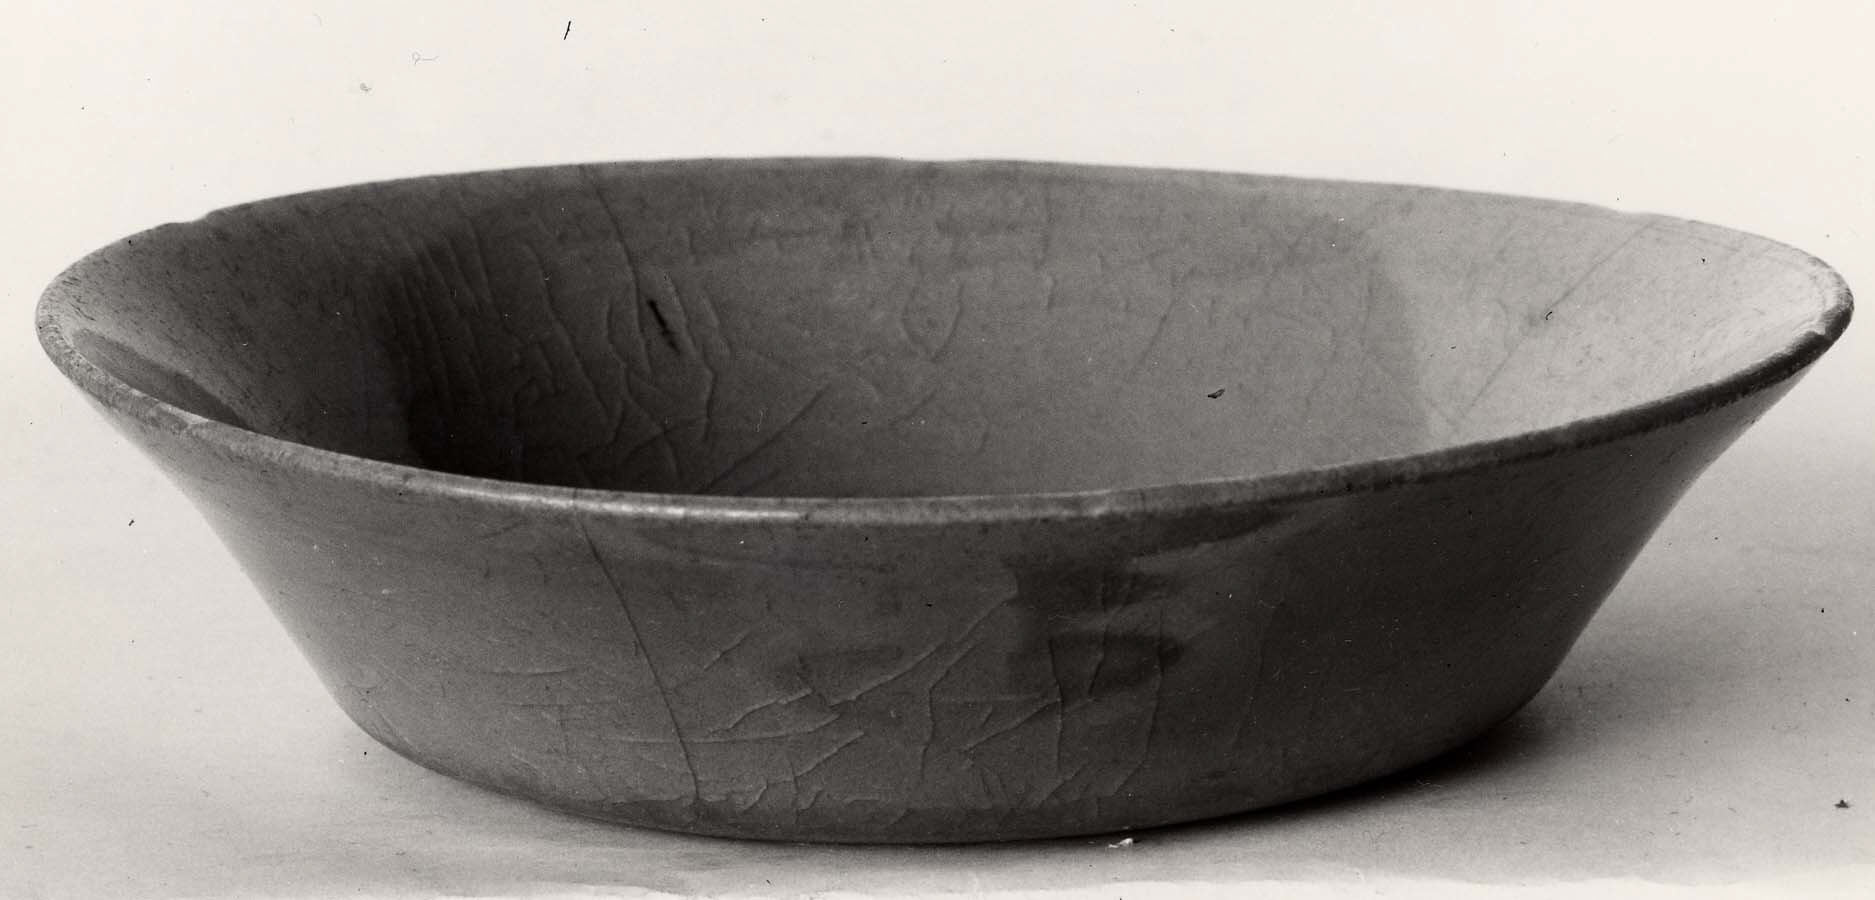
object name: saucer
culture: korean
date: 918-1392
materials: clay